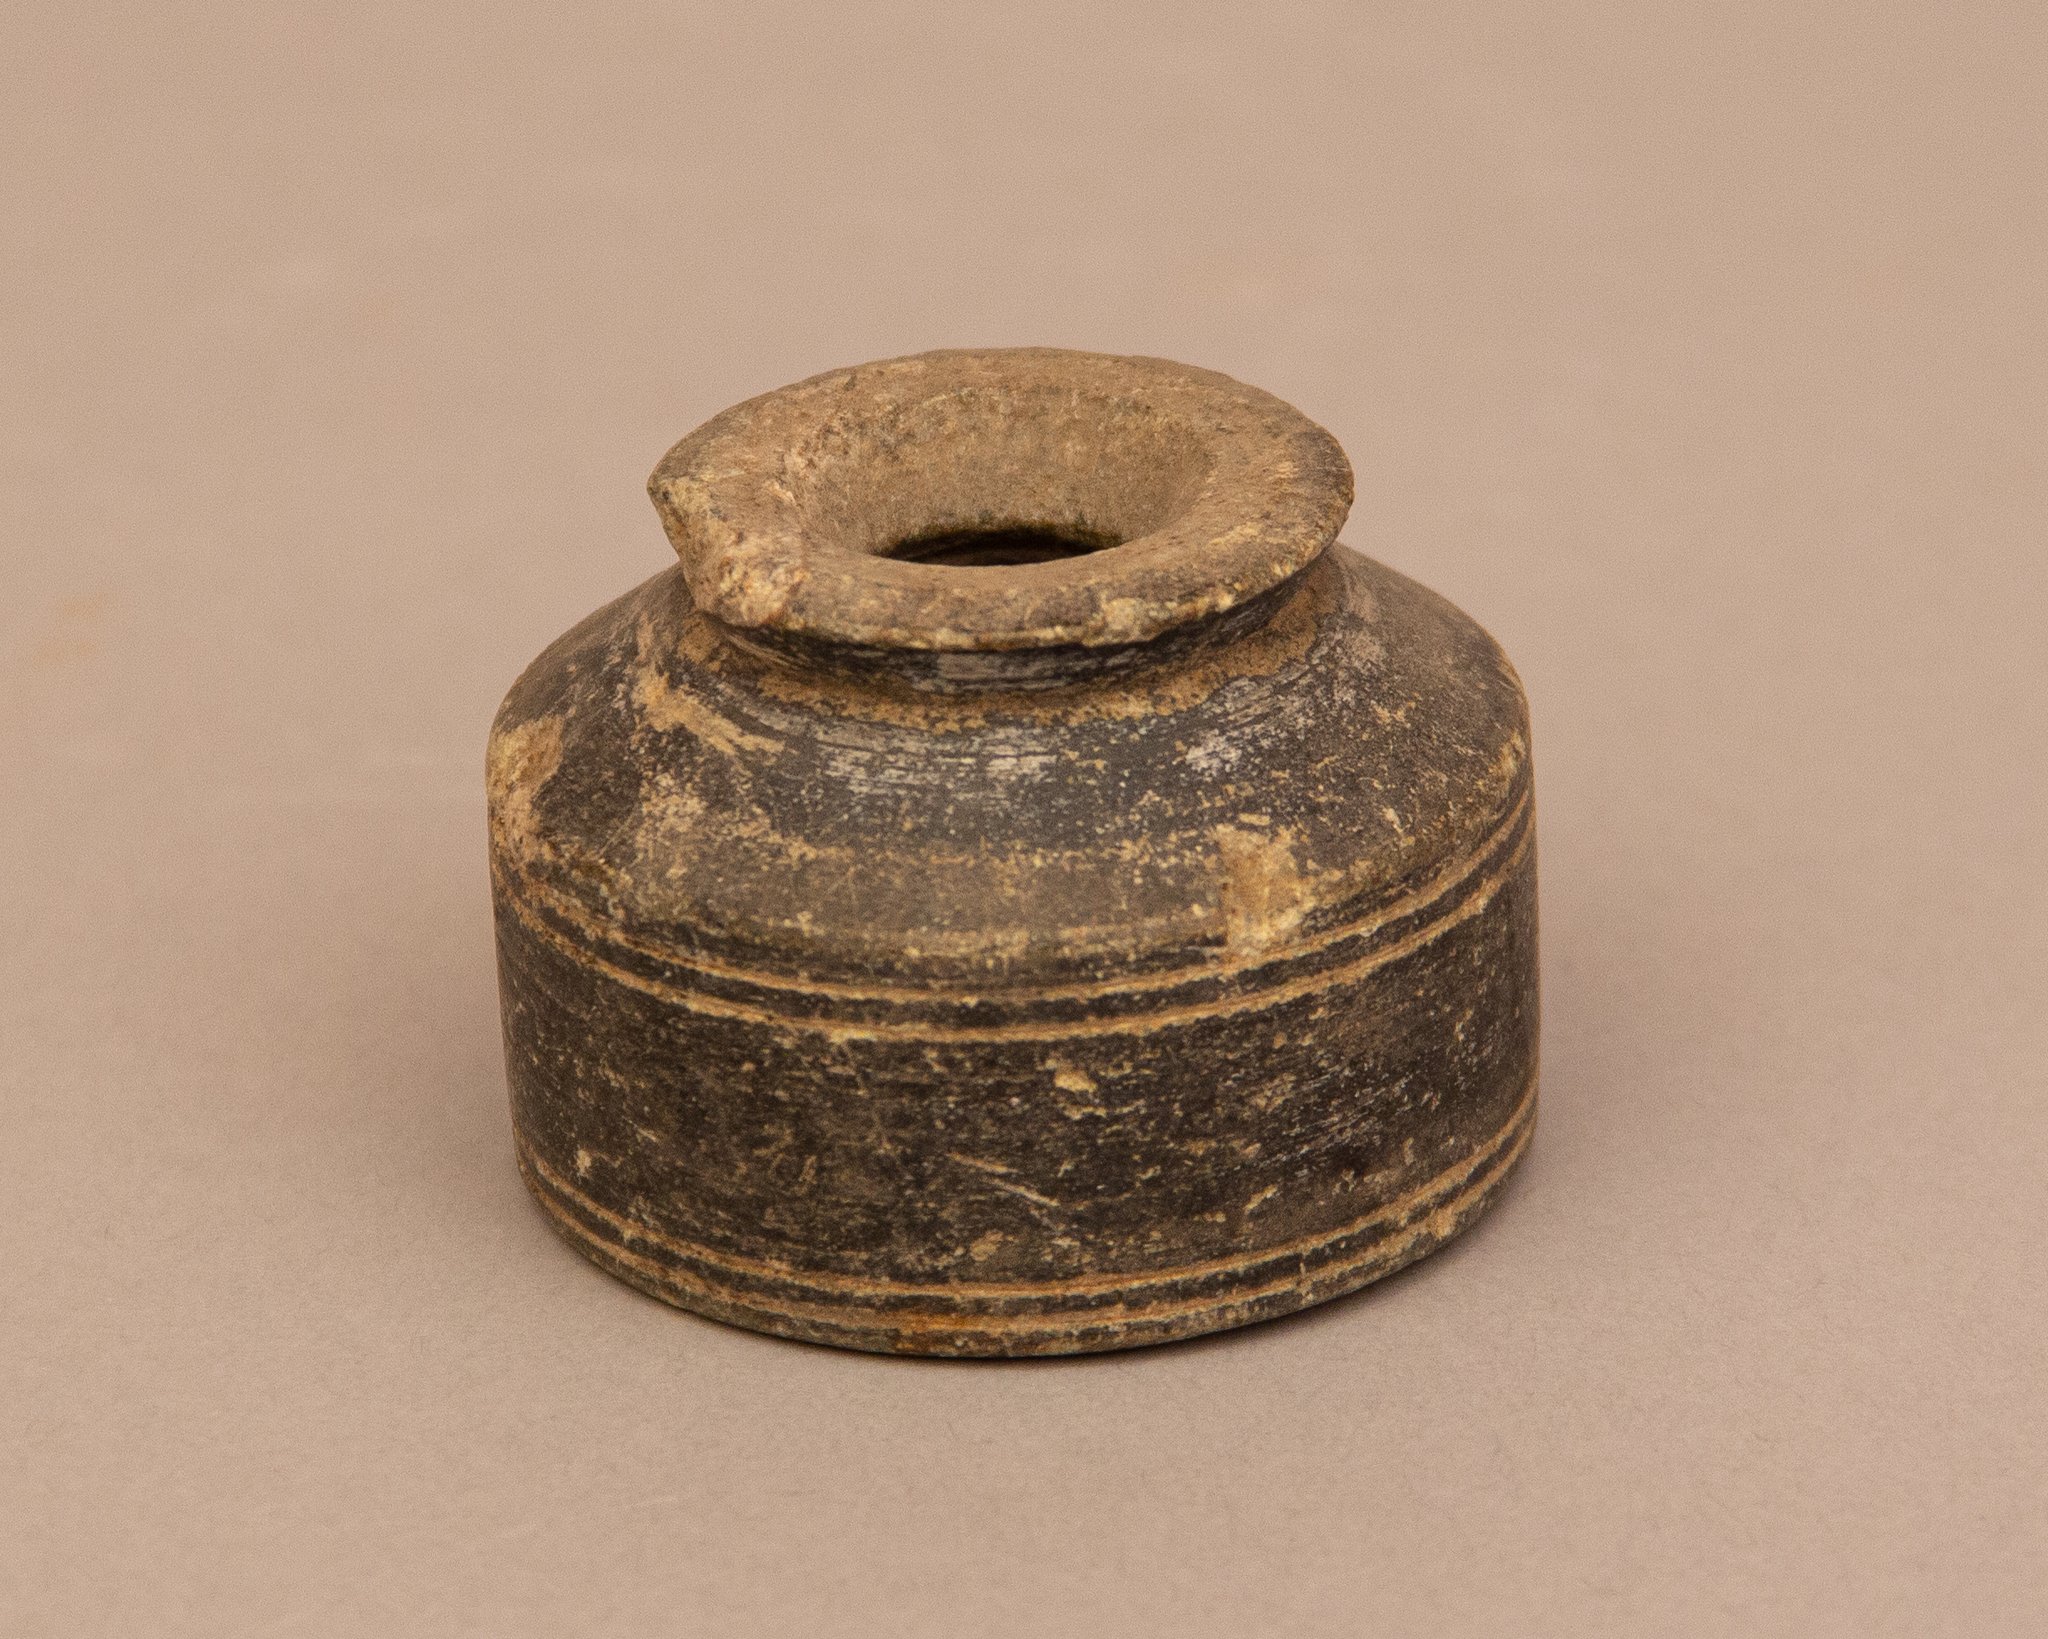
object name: pot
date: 901-1200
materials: stone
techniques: carving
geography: iran